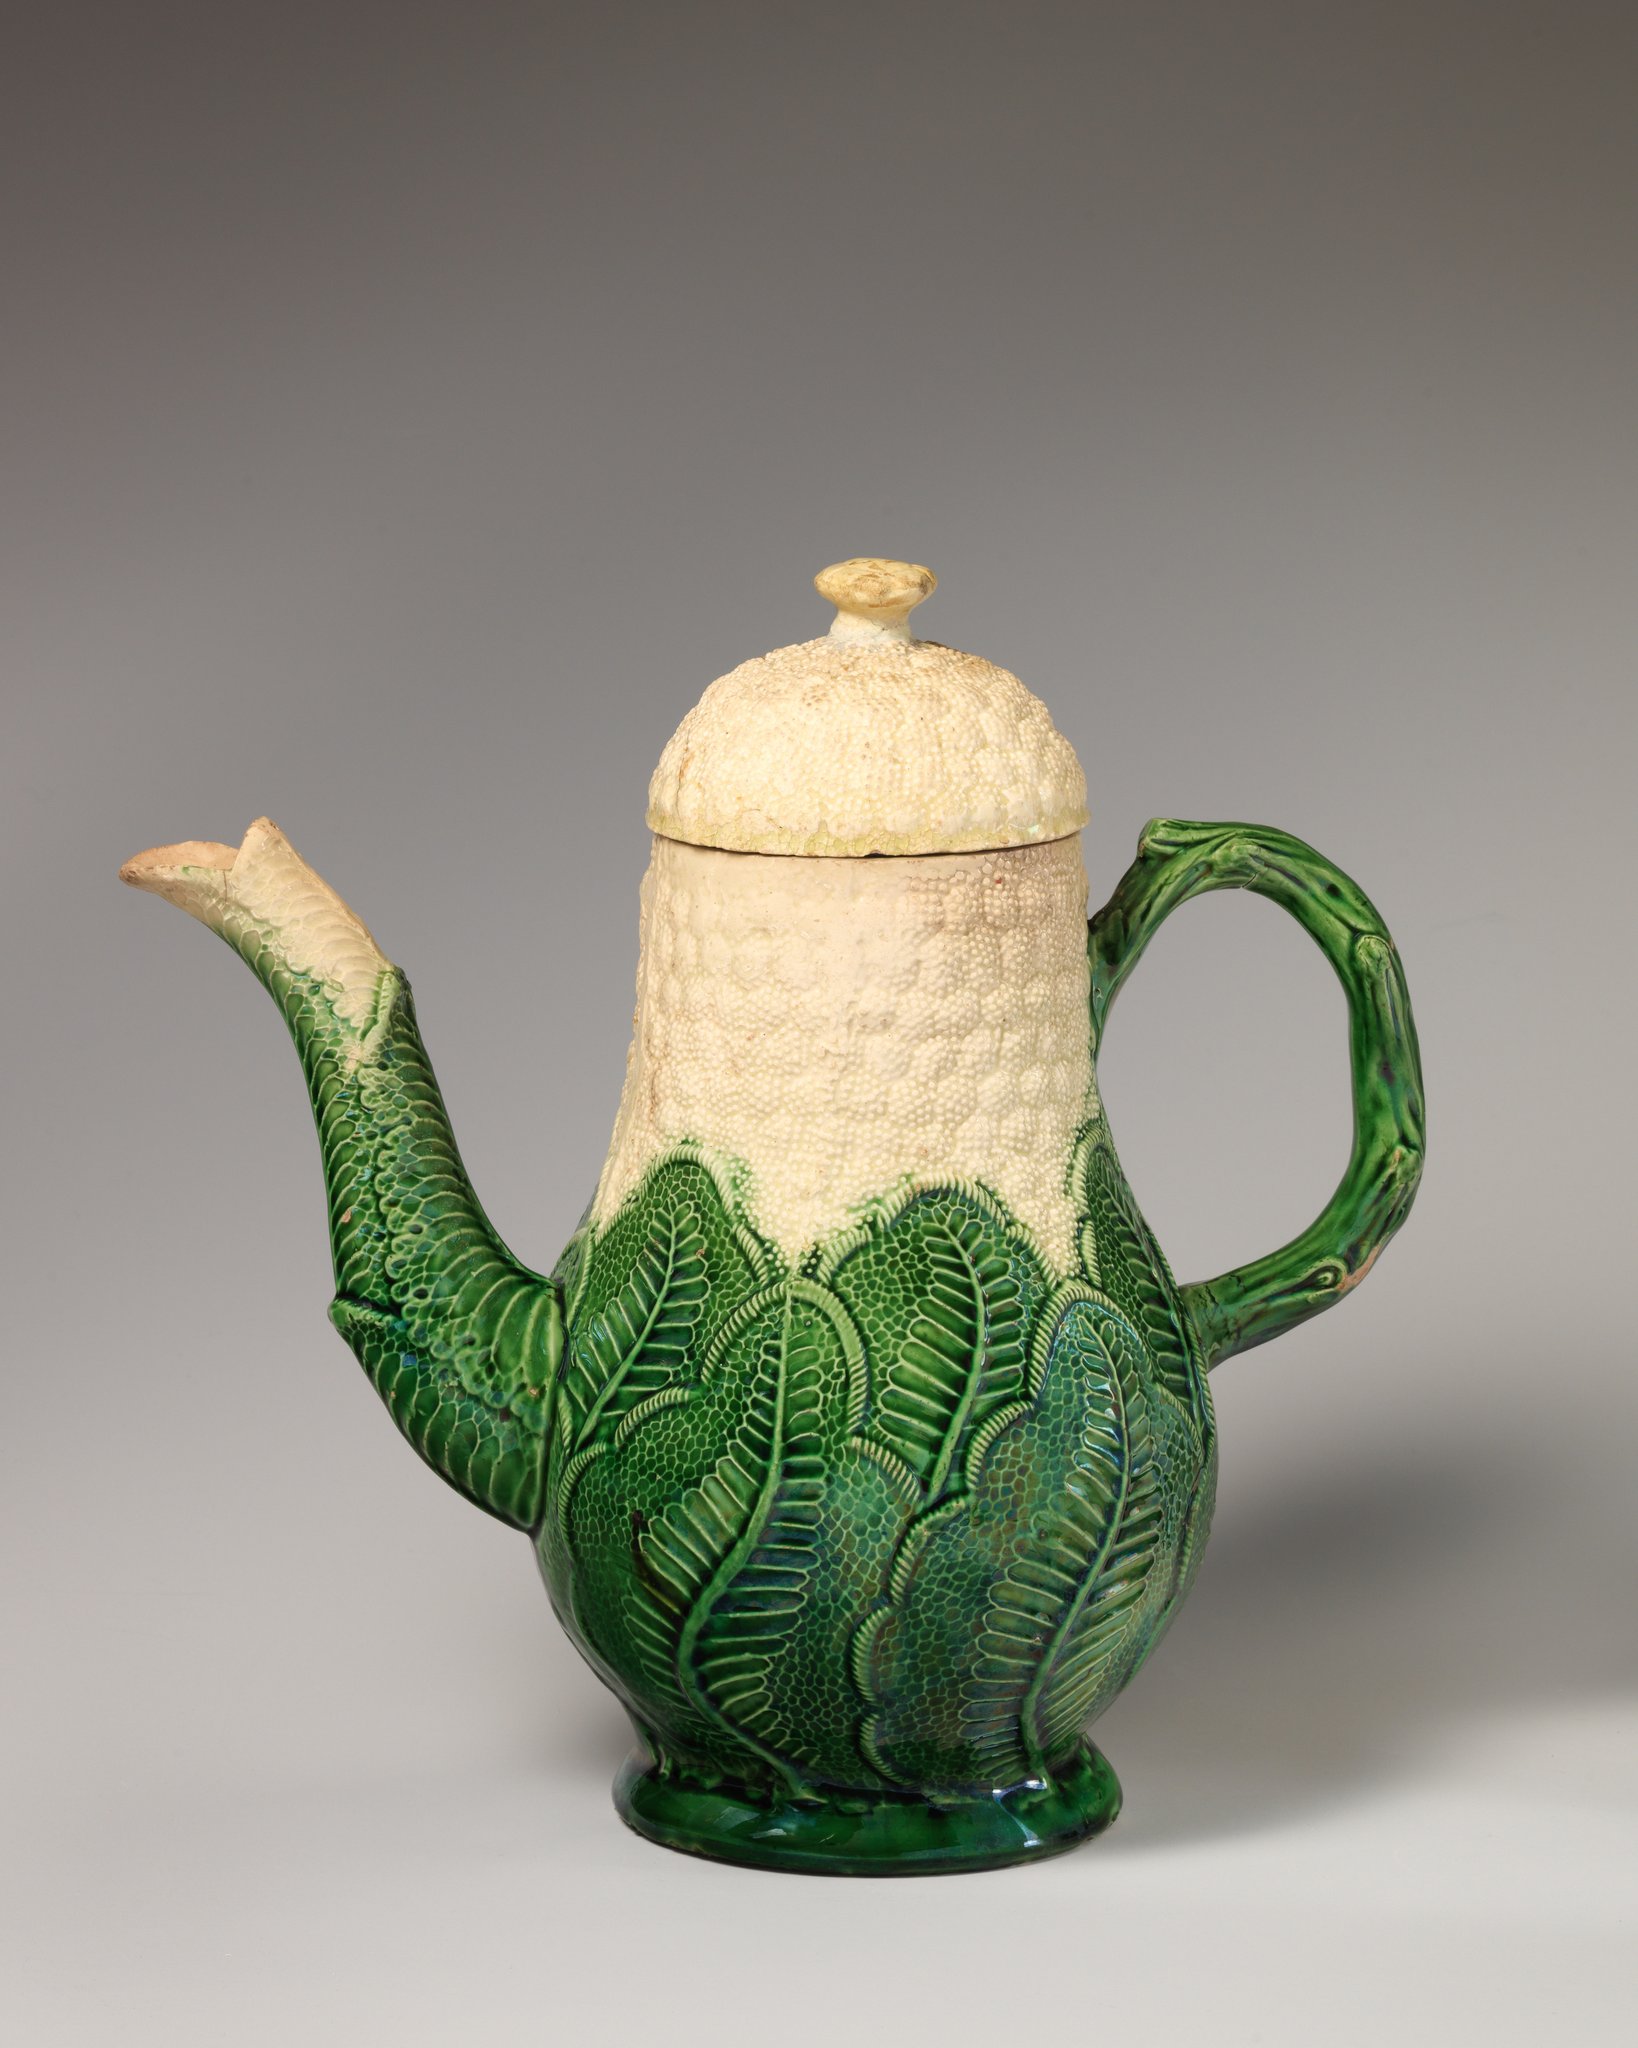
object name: chocolate pot with cover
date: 1755-1770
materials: earthenware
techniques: glazing